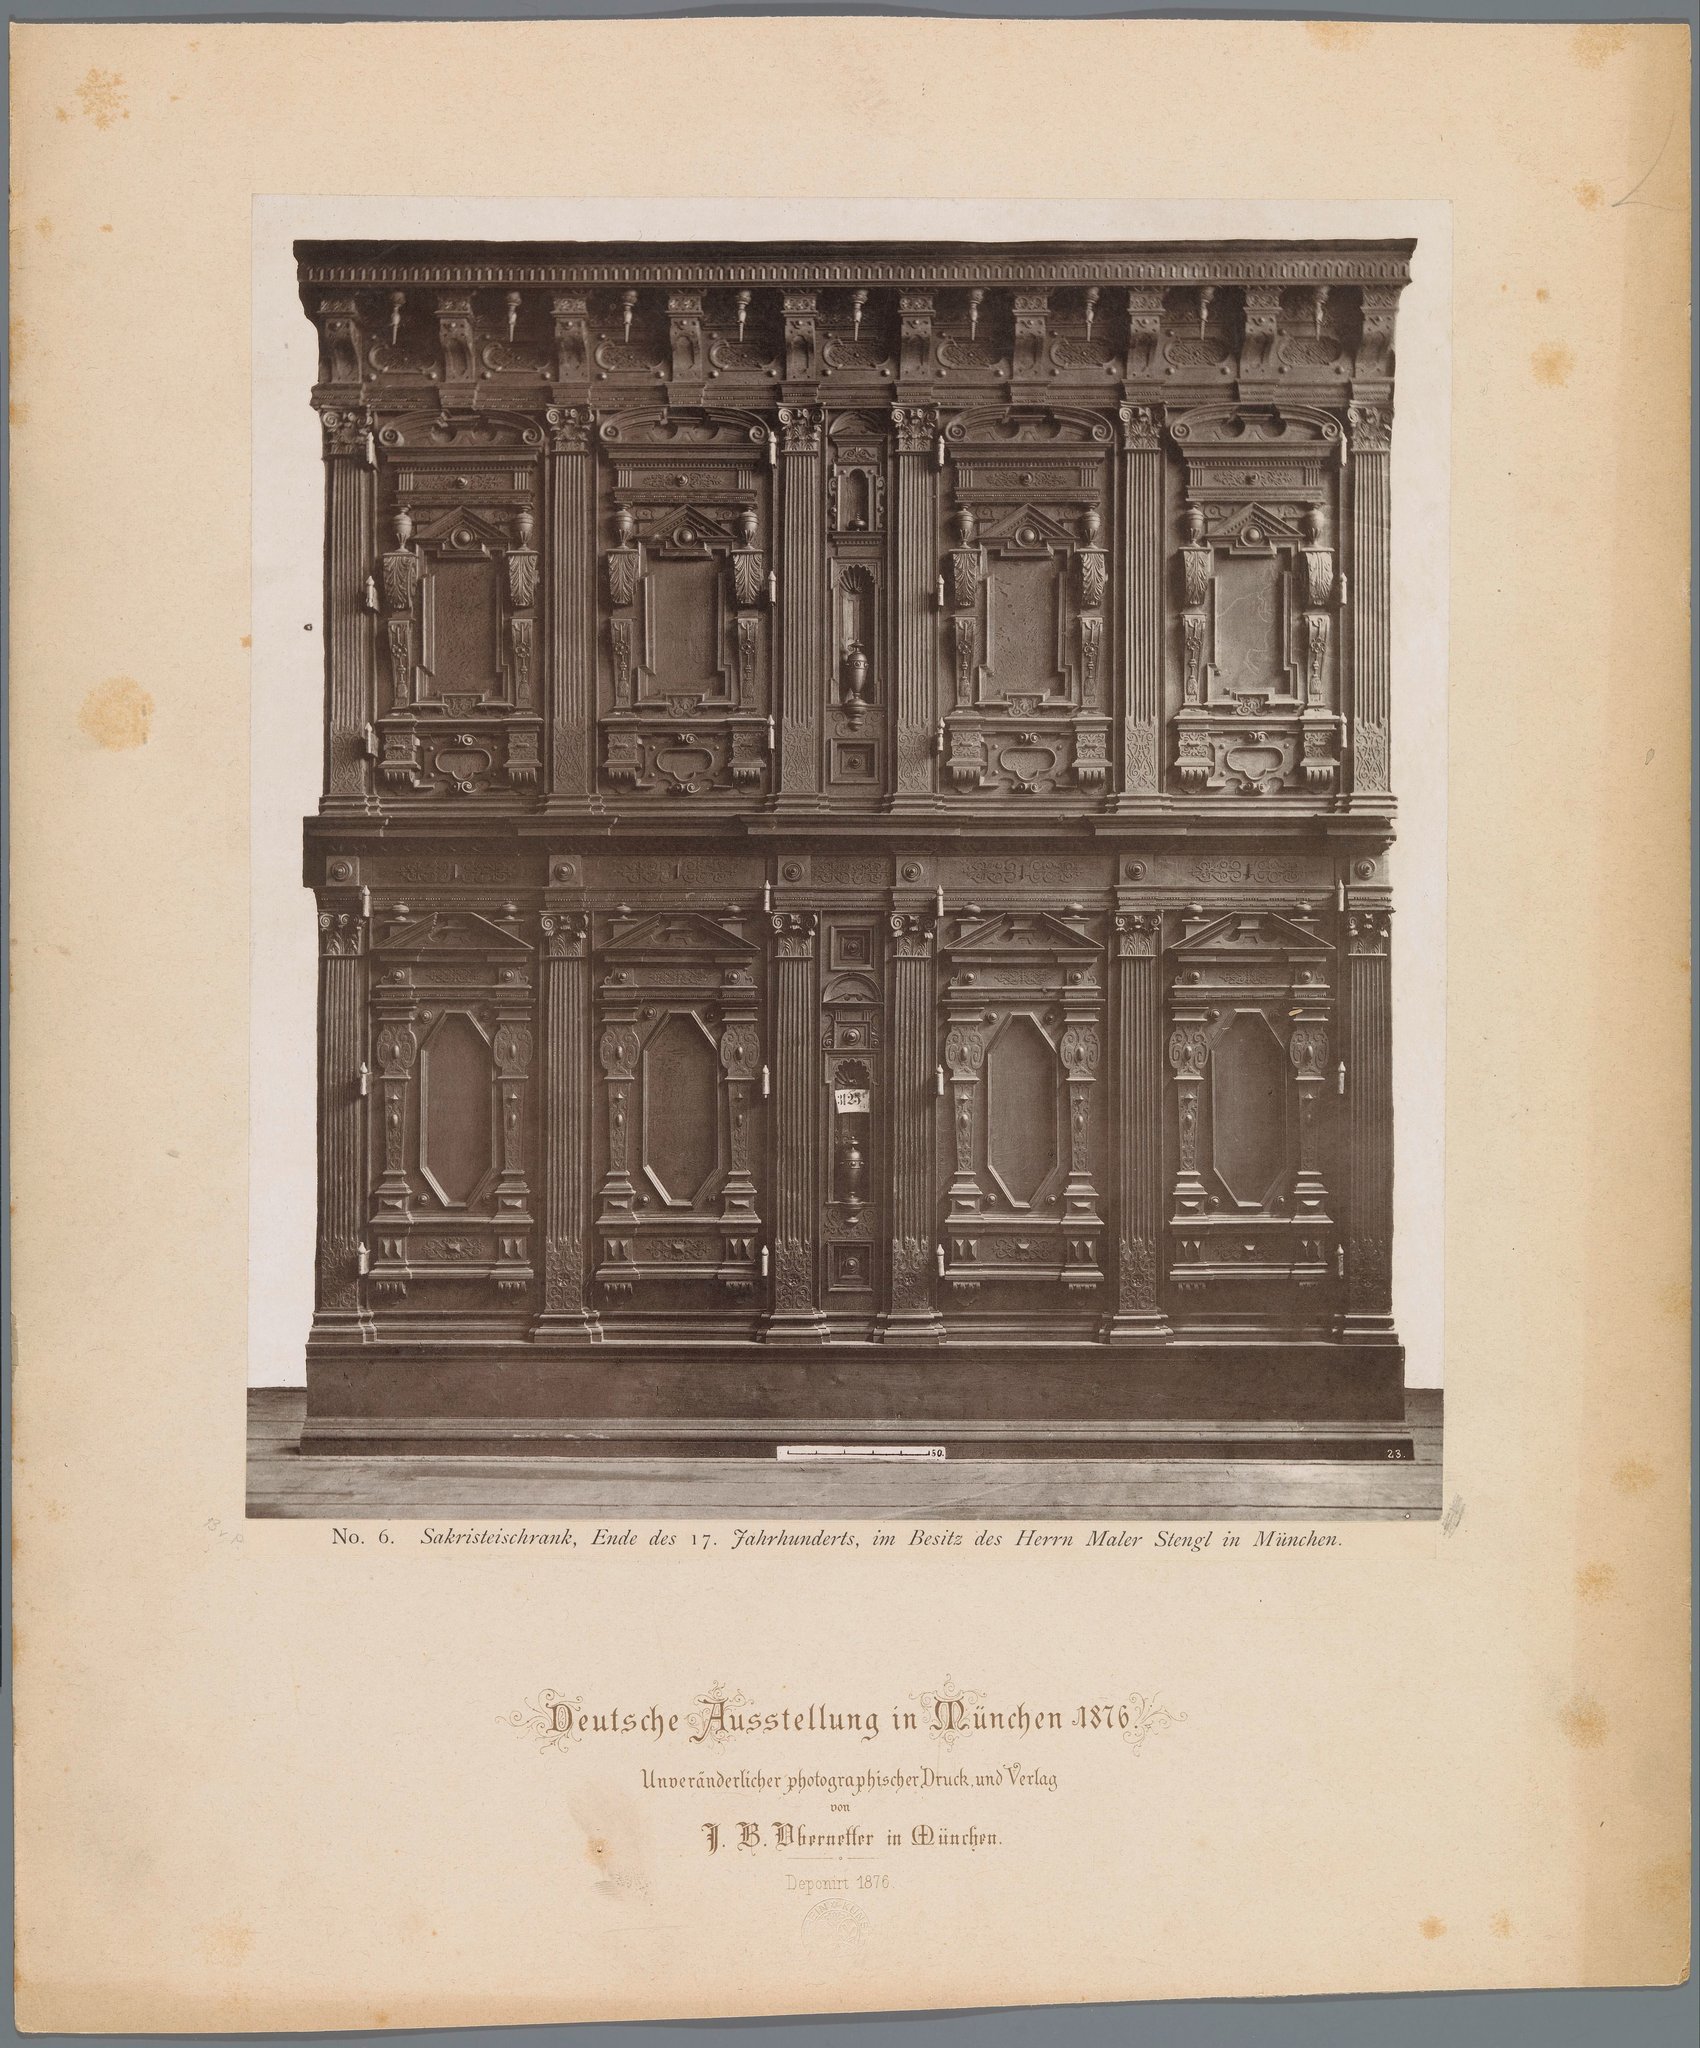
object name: photomechanical print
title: Sakristeischrank, Ende des 17. Jahrhunderts, im Besitz des Herrn Maler Stengl in München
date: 1876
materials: cardboard, paper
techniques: photograph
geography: munich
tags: cupboard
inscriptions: number: ‘No. 6.’, collector's mark: Lugt 3937, number: ‘23.’, name: ‘Verein Kunst [...]’, inscription: ‘Deutsche Ausstellung in München 1876.’